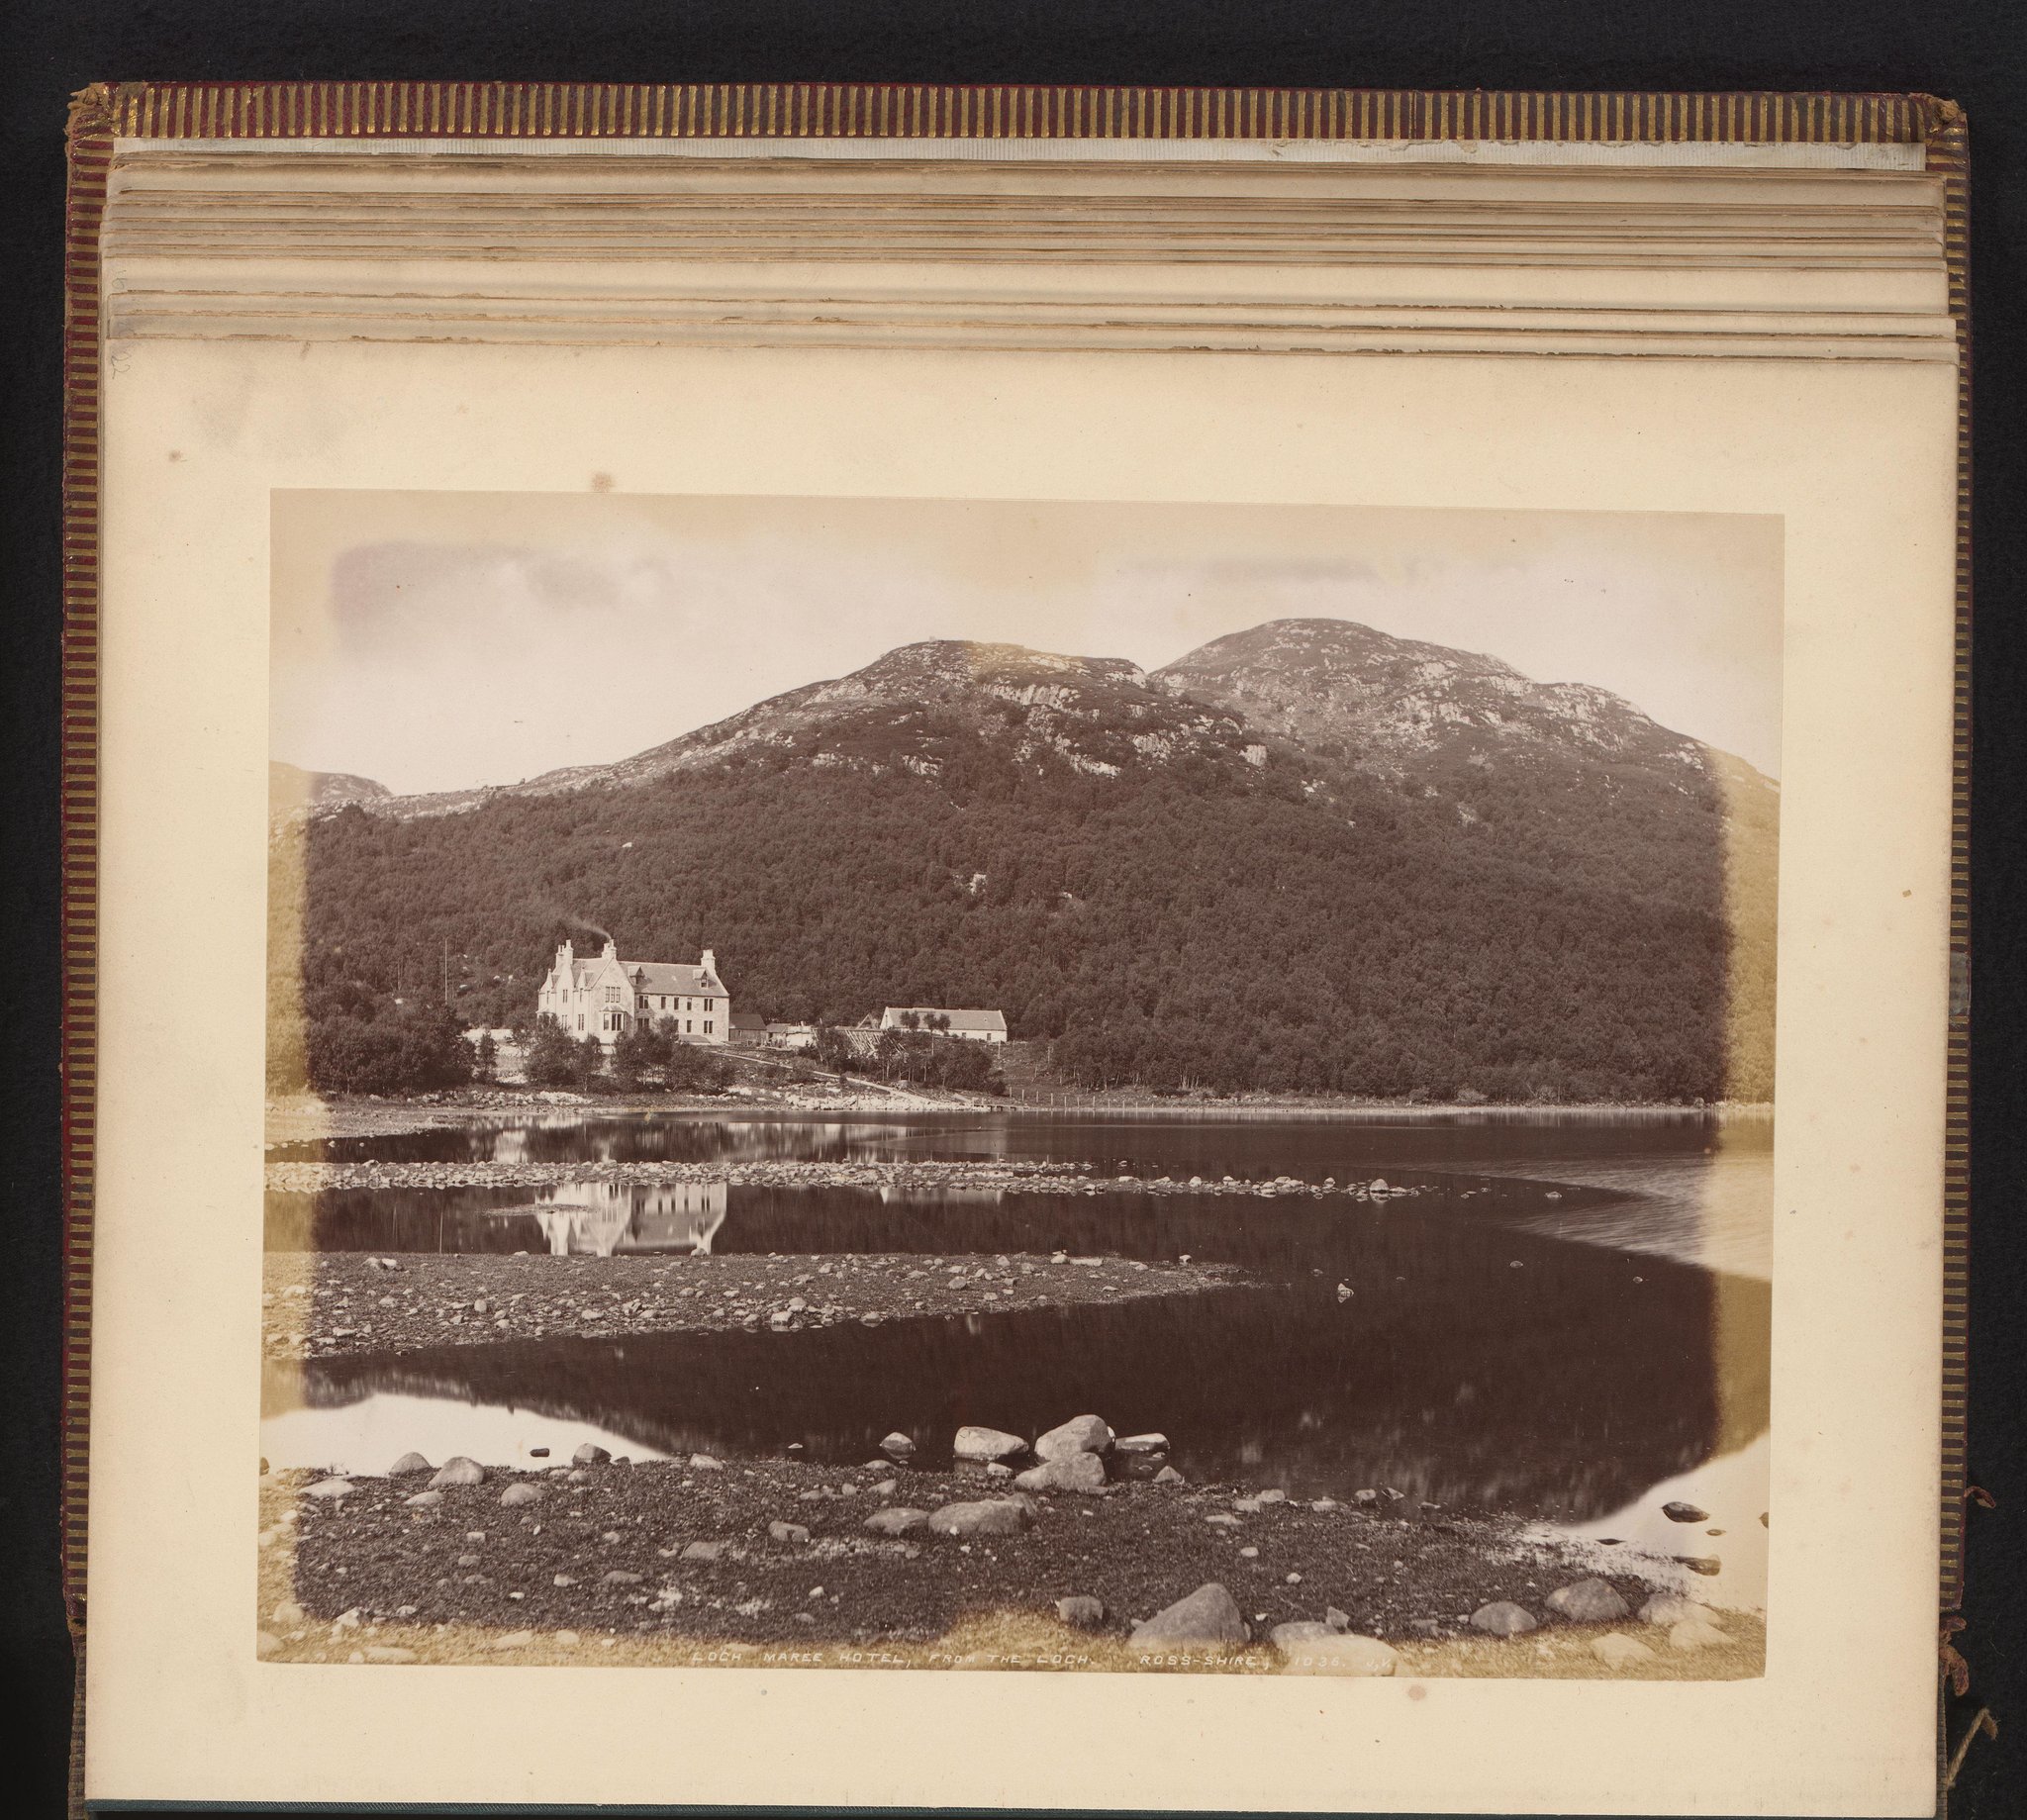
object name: album leaf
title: Gezicht op Loch Maree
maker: Anonymous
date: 1875-1885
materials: photographic support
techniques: albumen print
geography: loch maree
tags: fjord, sea loch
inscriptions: number: ‘1036, J.V.’